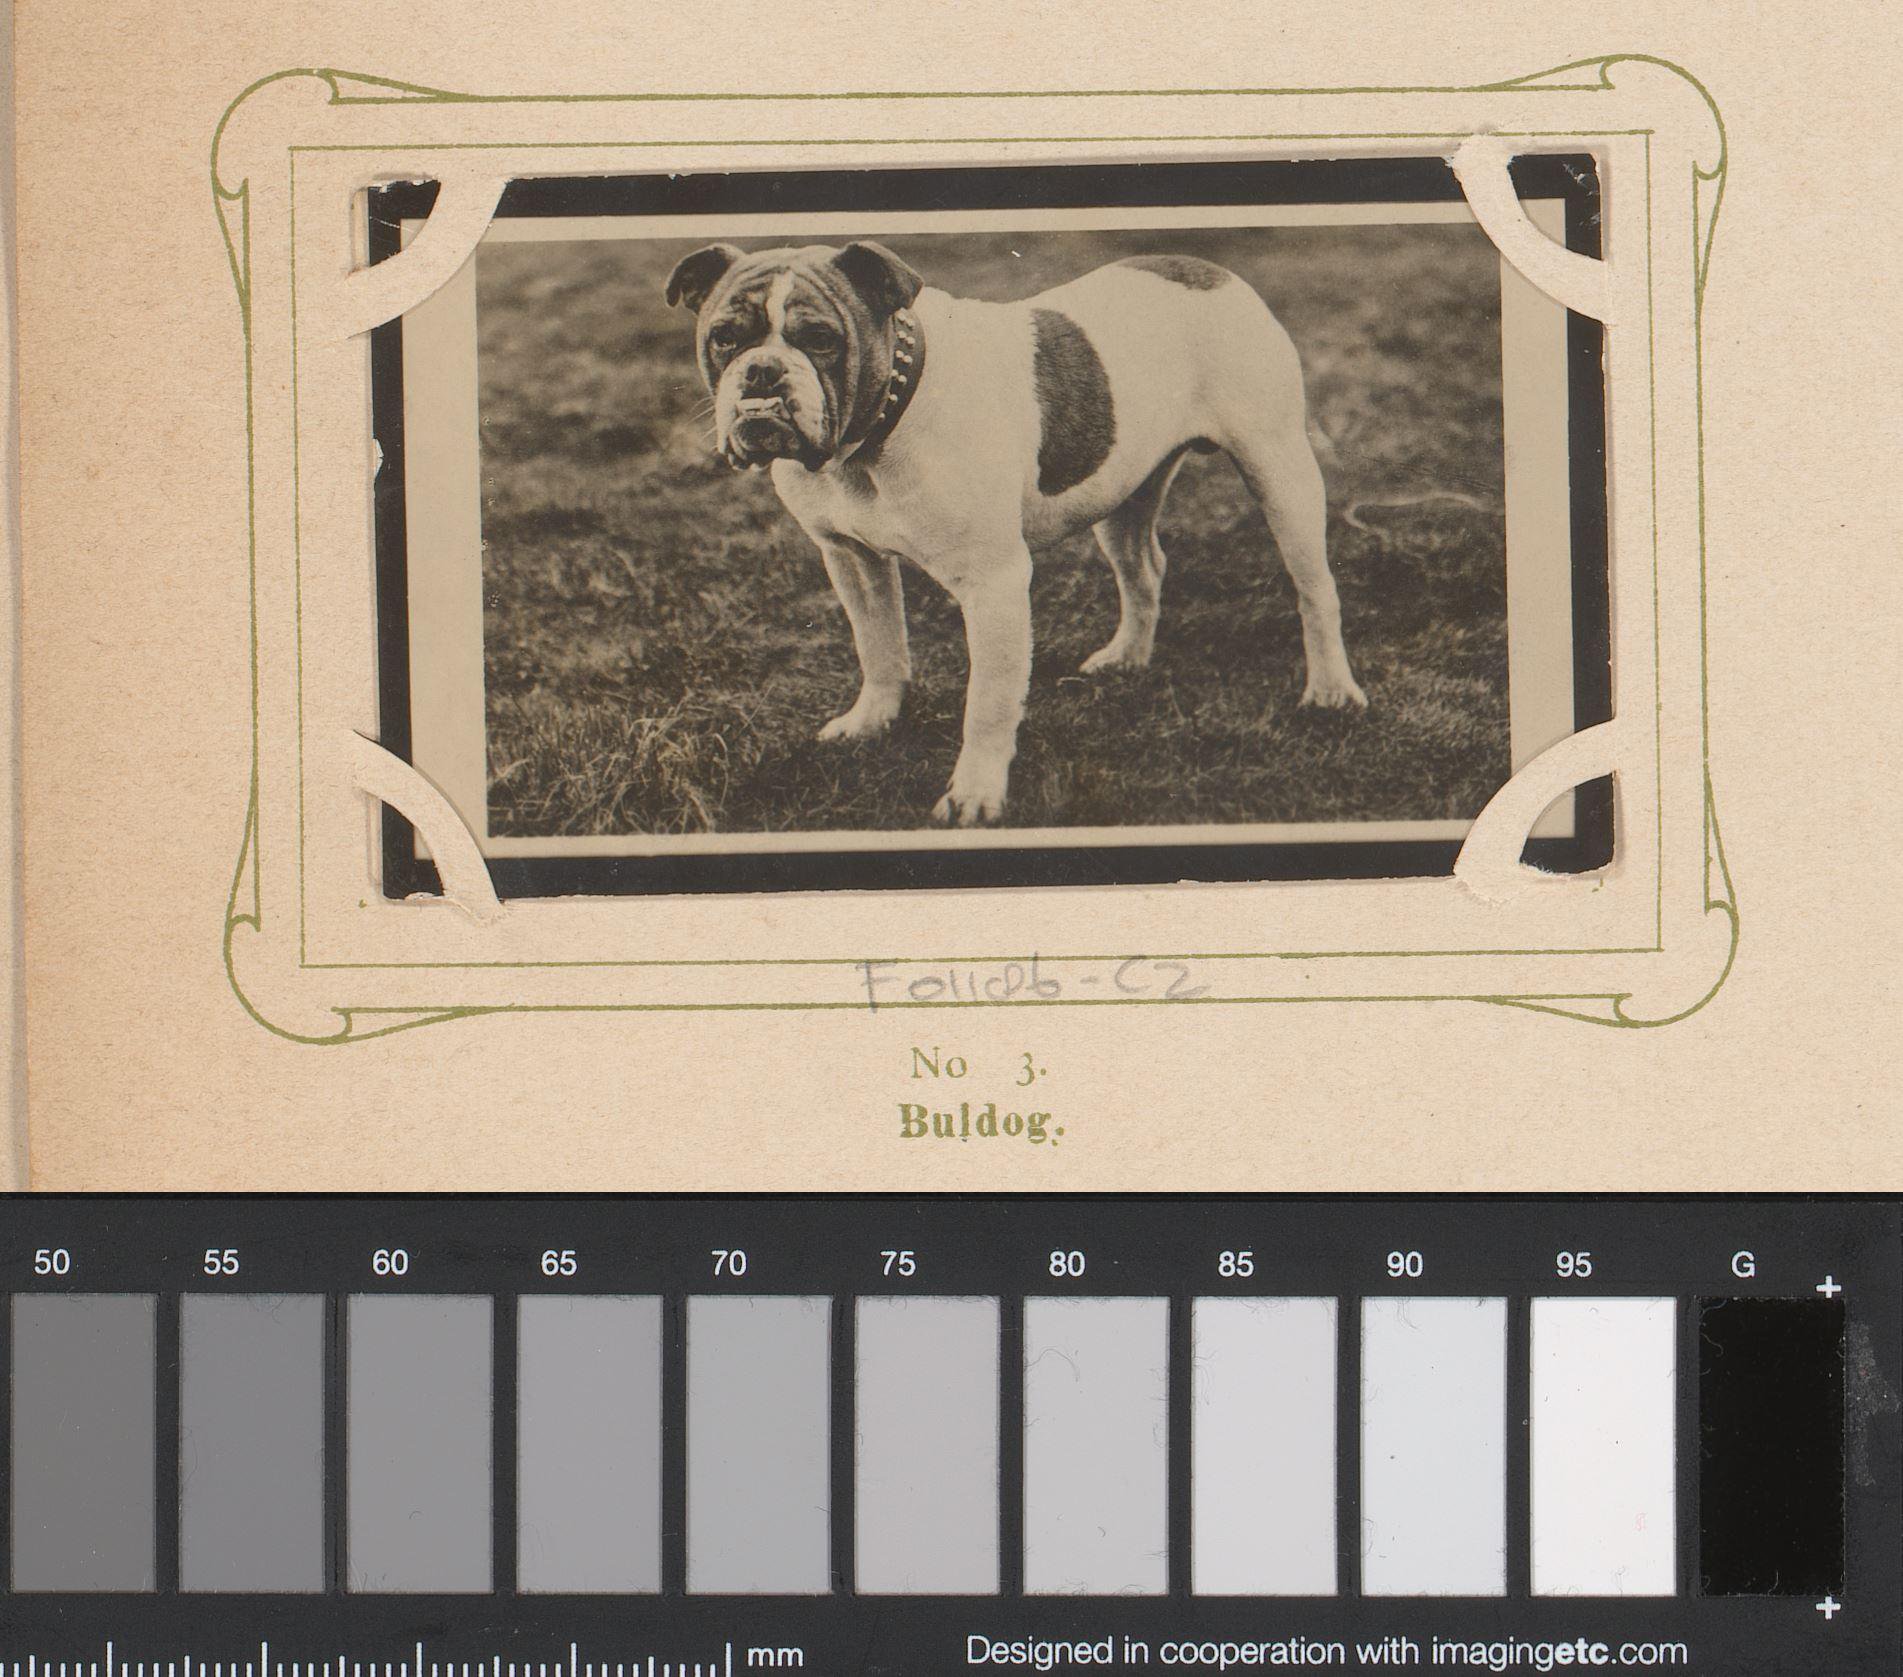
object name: album leaf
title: Buldog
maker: Anonymous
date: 1904-1905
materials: photographic support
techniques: gelatin silver print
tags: dog (with name of kind)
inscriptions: inscription: ‘No. 3./ Buldog.’